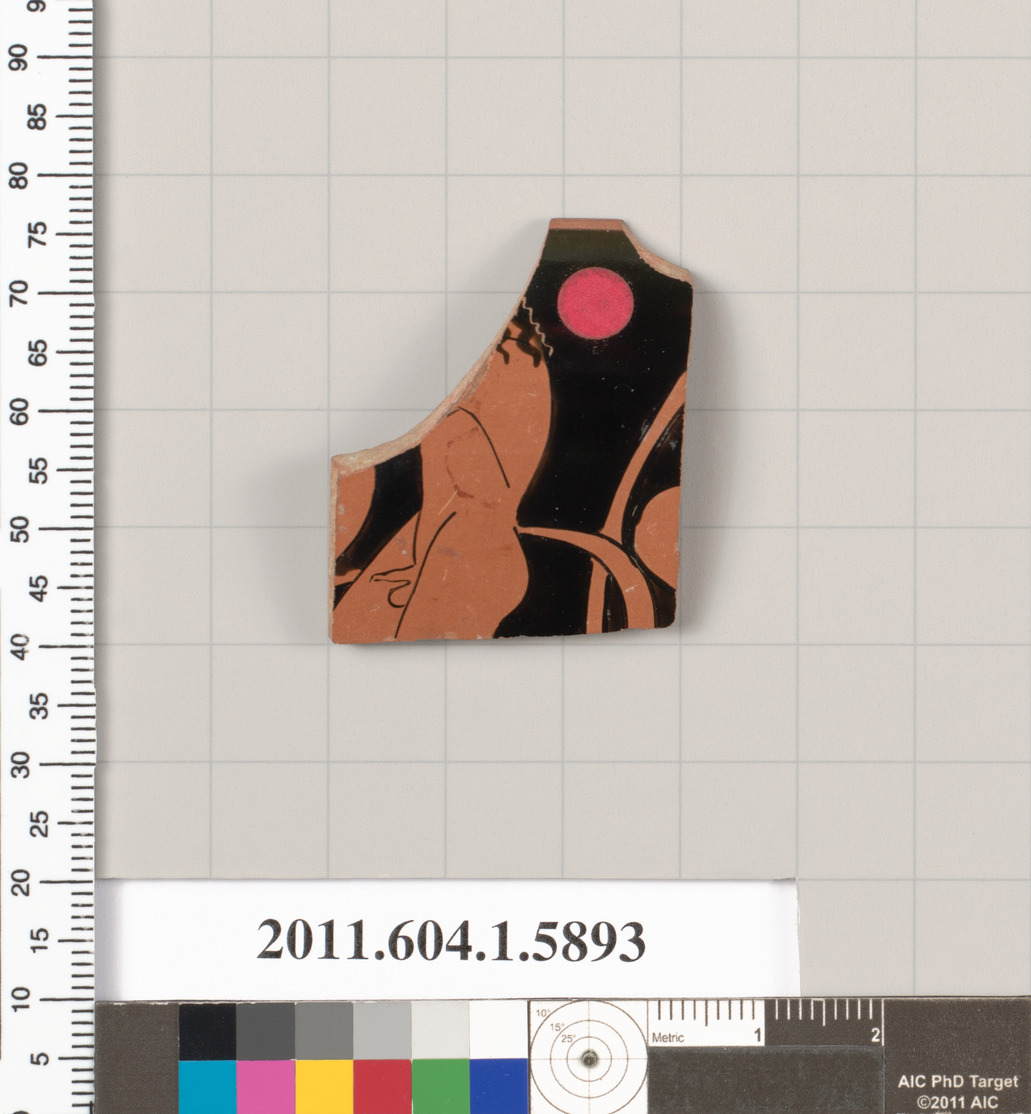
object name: kylix fragment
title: Terracotta rim fragment of a kylix (drinking cup)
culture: greek, attic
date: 520-510 BCE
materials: terracotta